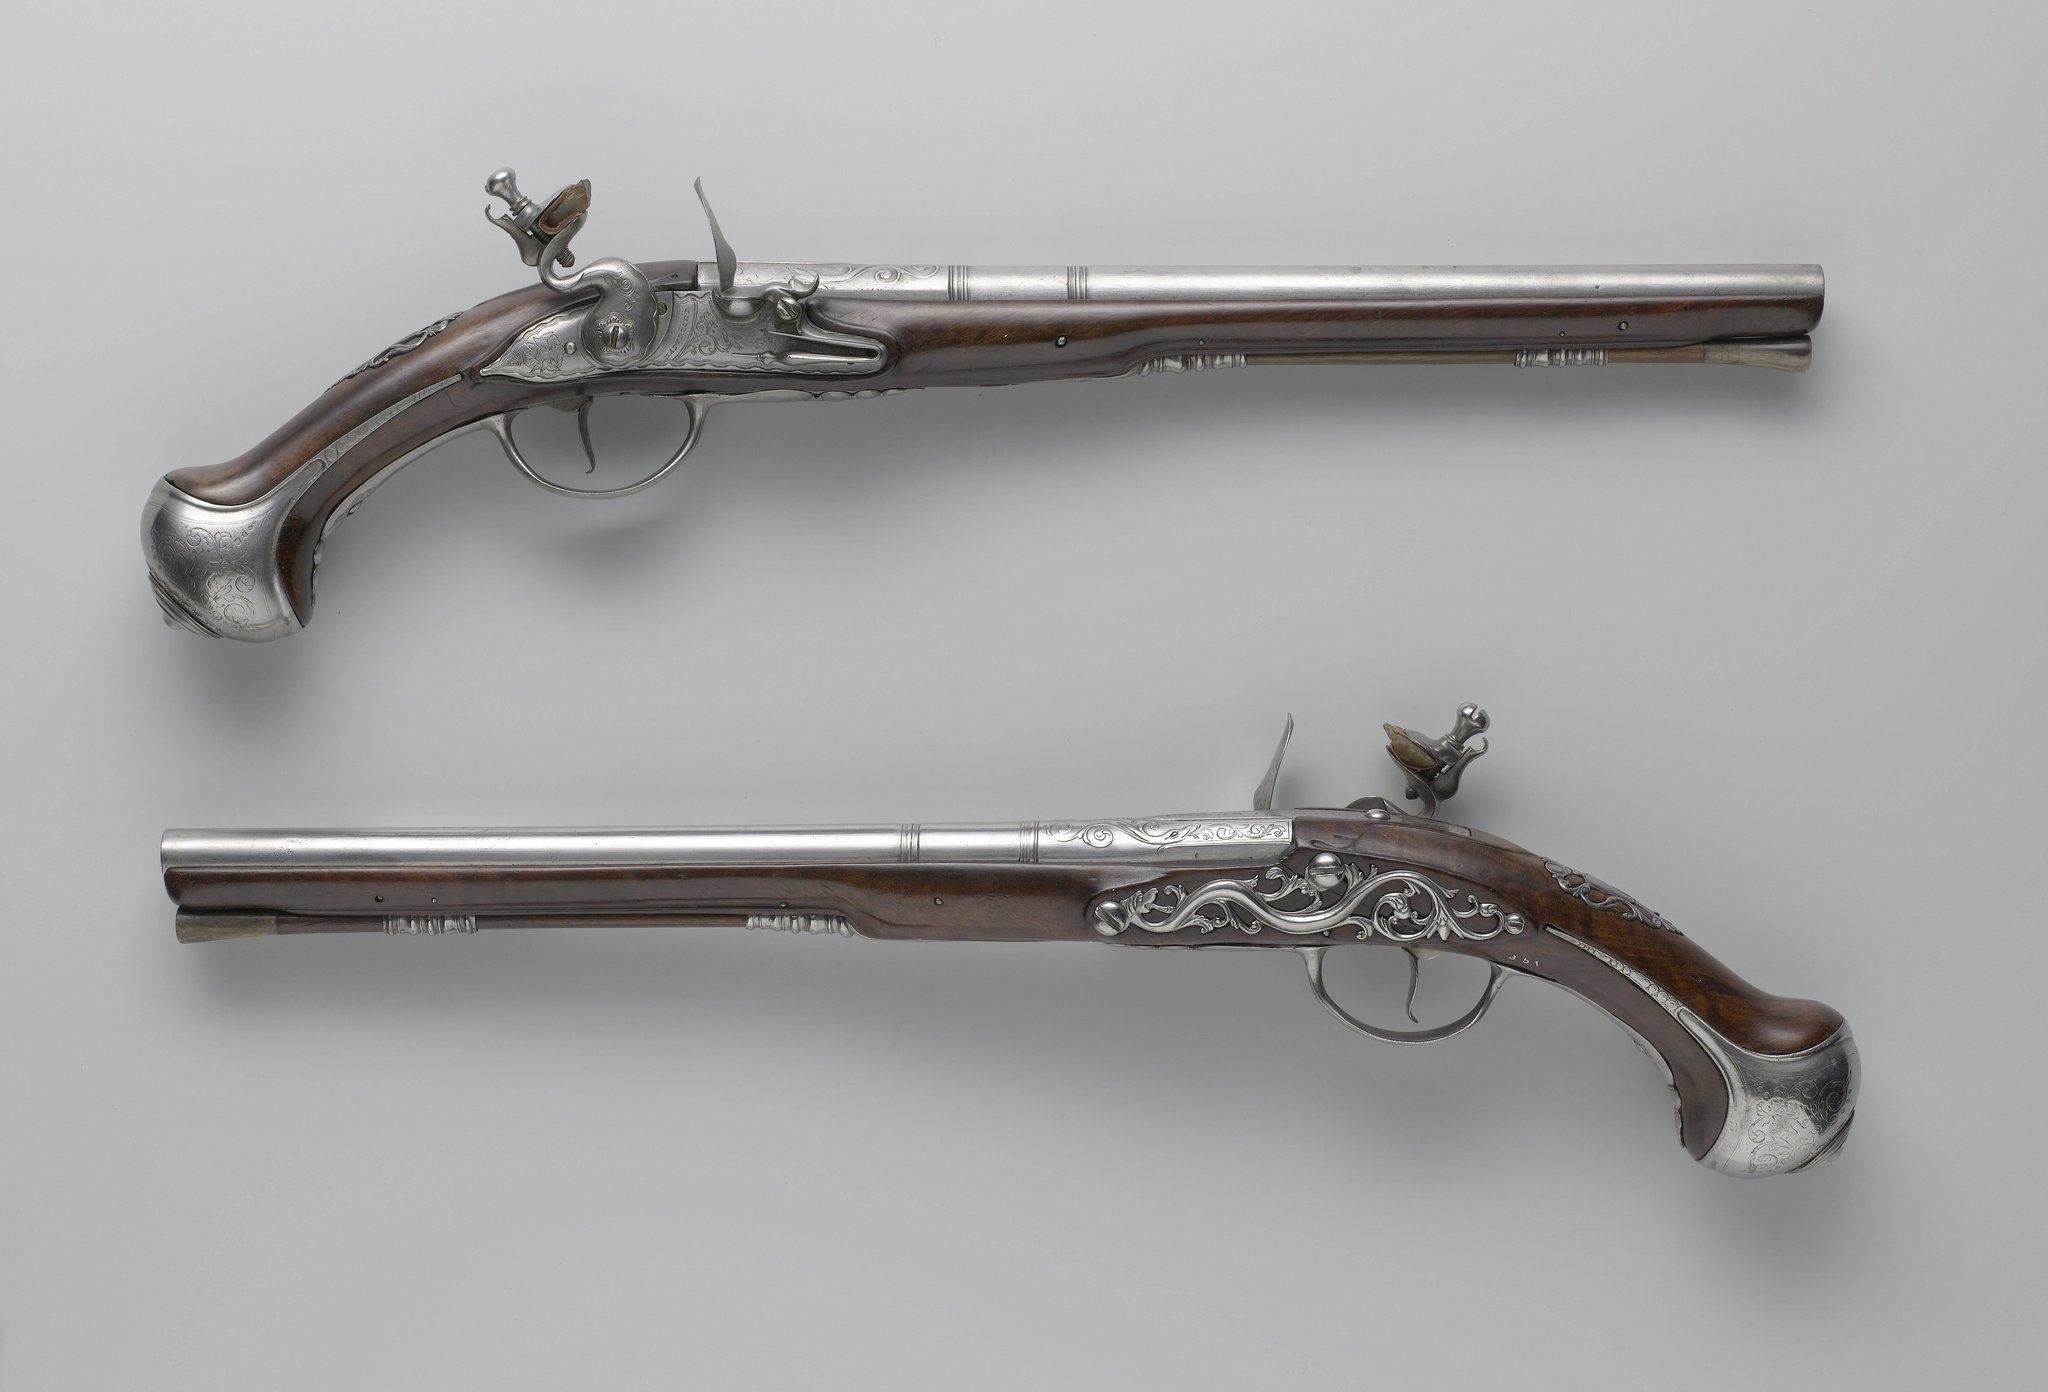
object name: flintlock pistol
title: Vuursteenpistool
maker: j wilkin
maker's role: geweermaker, pistoolmaker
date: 1685-1690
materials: horn, iron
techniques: printing, cutting, engraving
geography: maastricht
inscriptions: inscription: ‘MASTRICHT’, coat of arms, mark, inscription: ‘I * WILKIN’